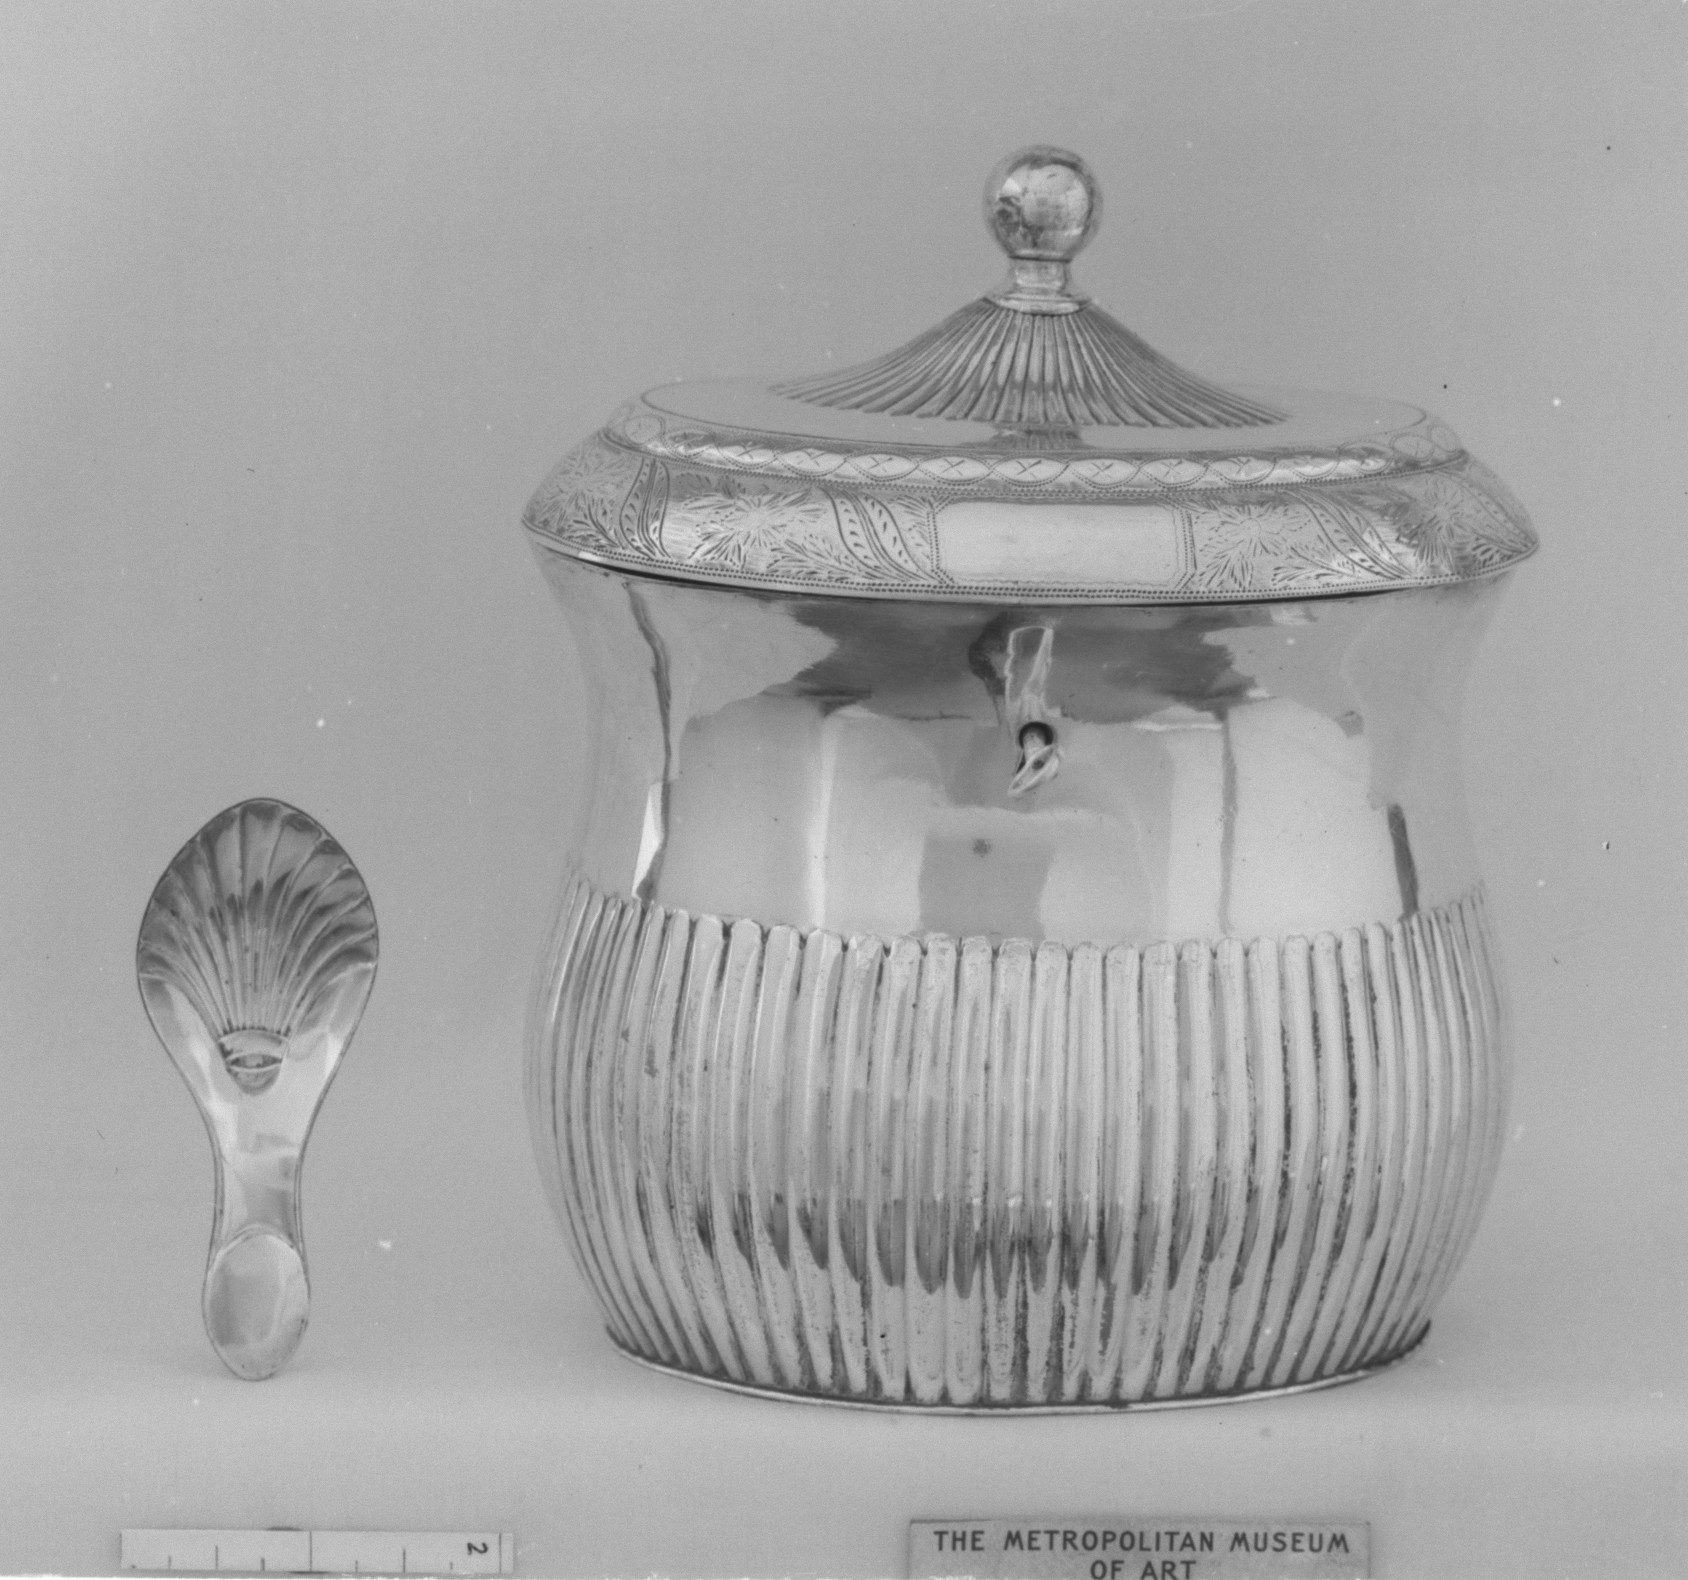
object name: tea caddy with spoon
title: Tea caddy and spoon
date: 1790-1800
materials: metal